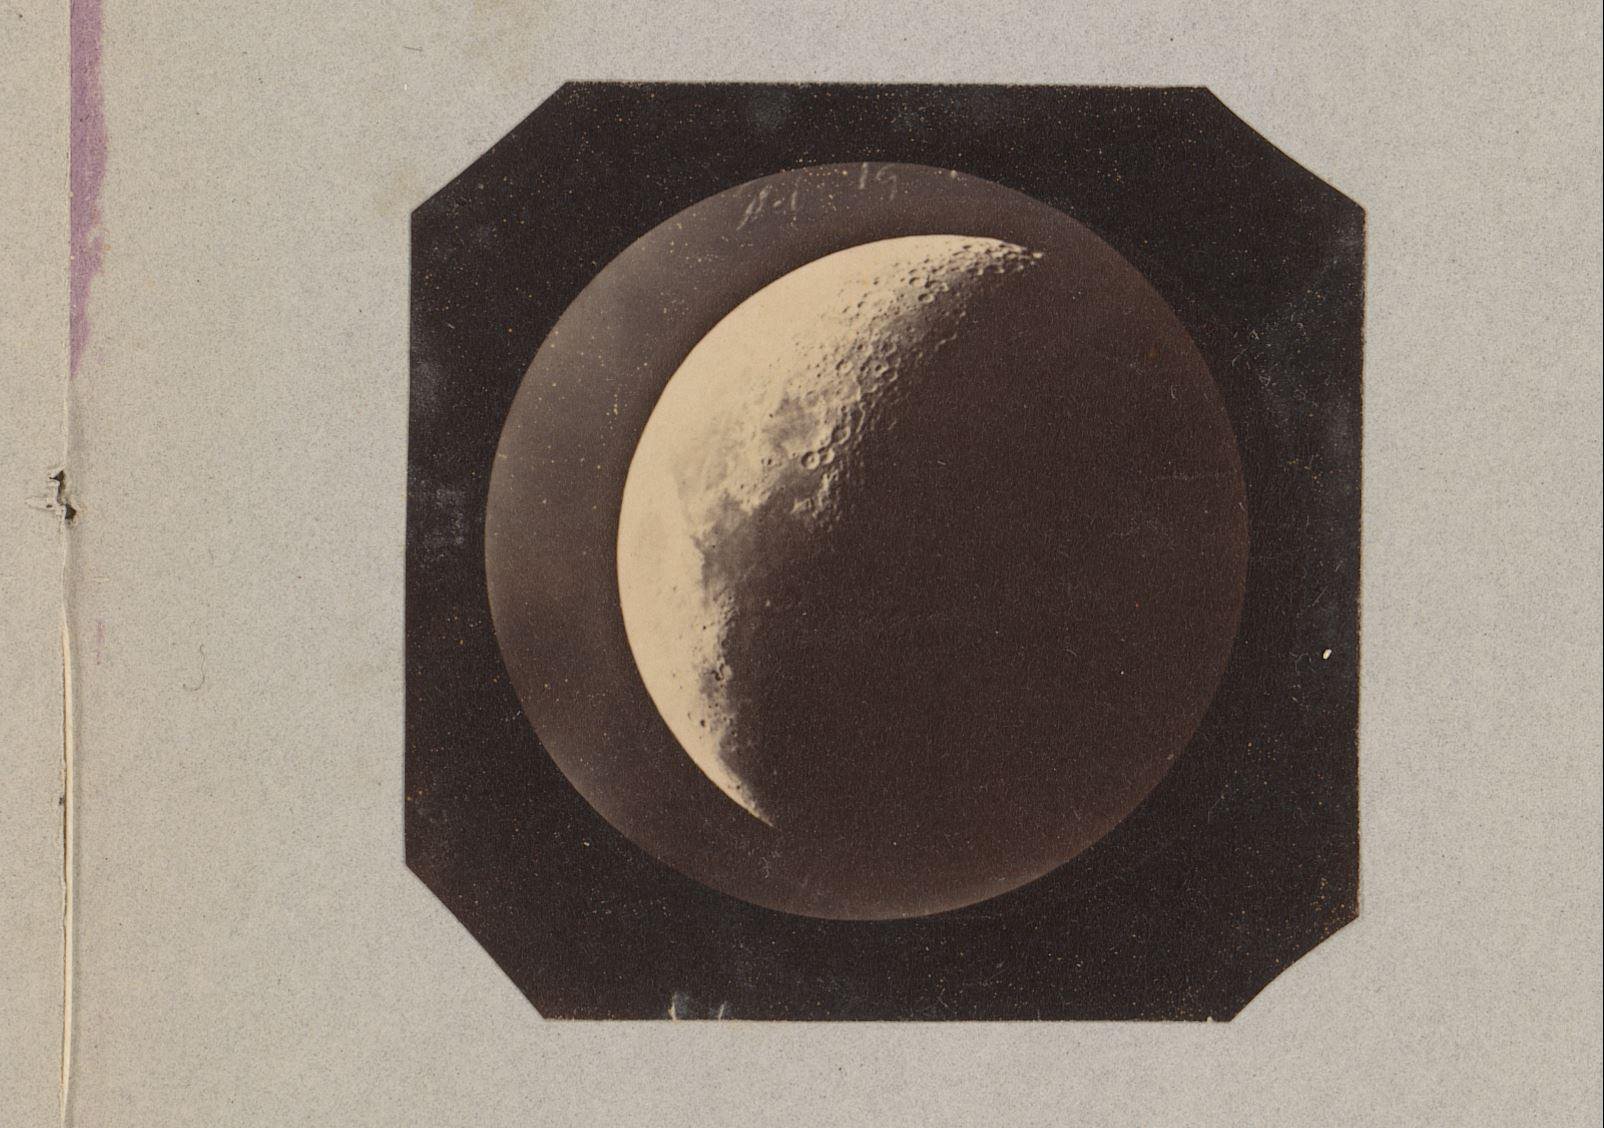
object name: photograph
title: Fotoreproductie van foto door Warren de la Rue van vlekken op de maan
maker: marinus pieter filbri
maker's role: instrument maker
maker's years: 1852-1917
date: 1887-1888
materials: paper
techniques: albumen print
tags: surface of the moon, moon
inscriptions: inscription: ‘Vlekken op de maan/ naar phot.’